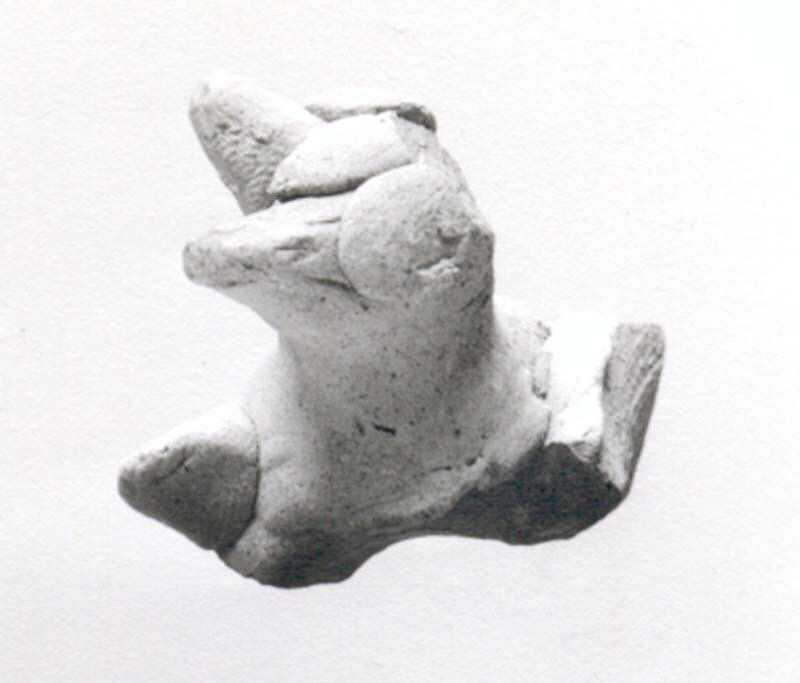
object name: handle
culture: sasanian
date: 201-700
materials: ceramic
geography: mesopotamia